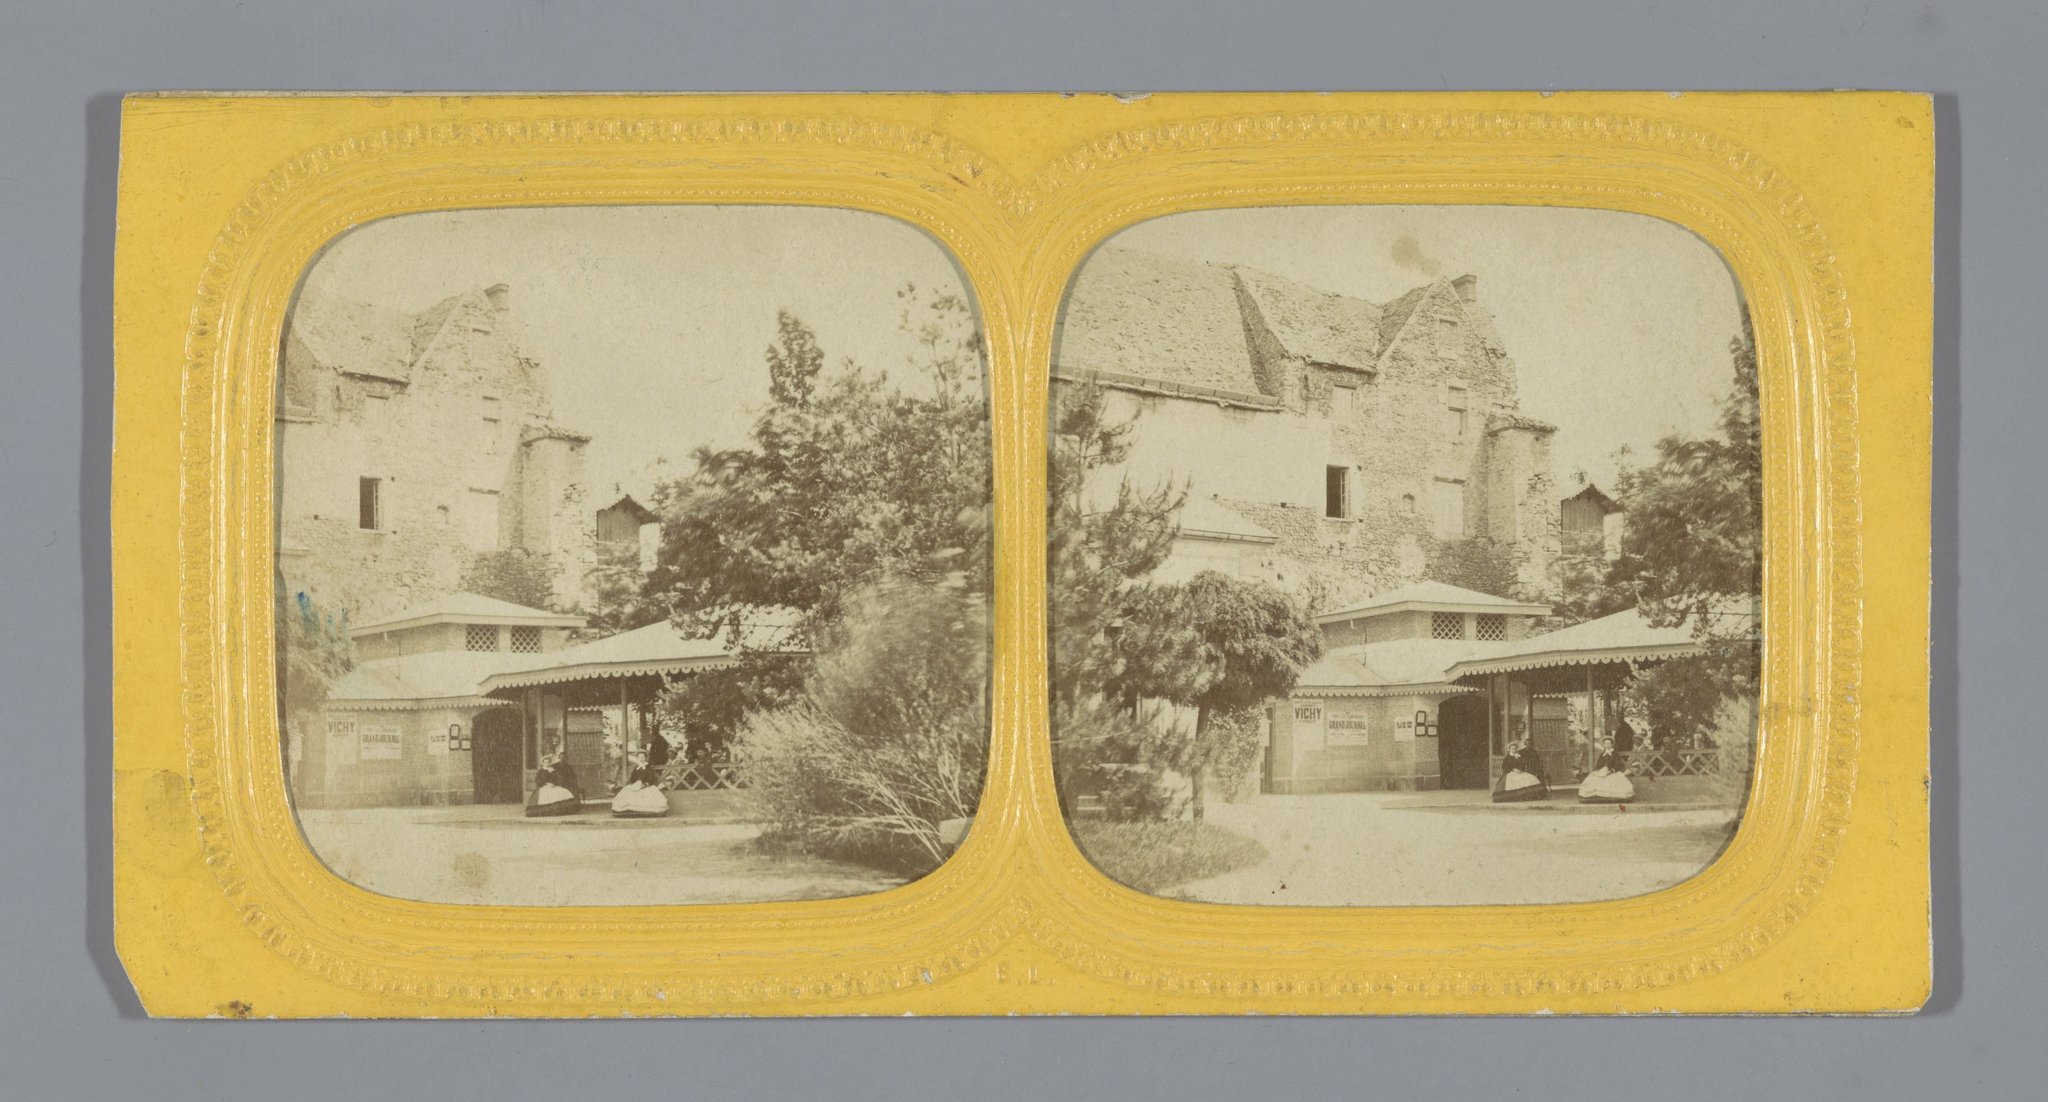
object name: tissue stereograph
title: Vichy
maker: Anonymous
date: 1855-1875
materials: cardboard, paper, photographic support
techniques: albumen print, hand coloring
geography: vichy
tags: street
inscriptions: monogram: ‘E.L.’